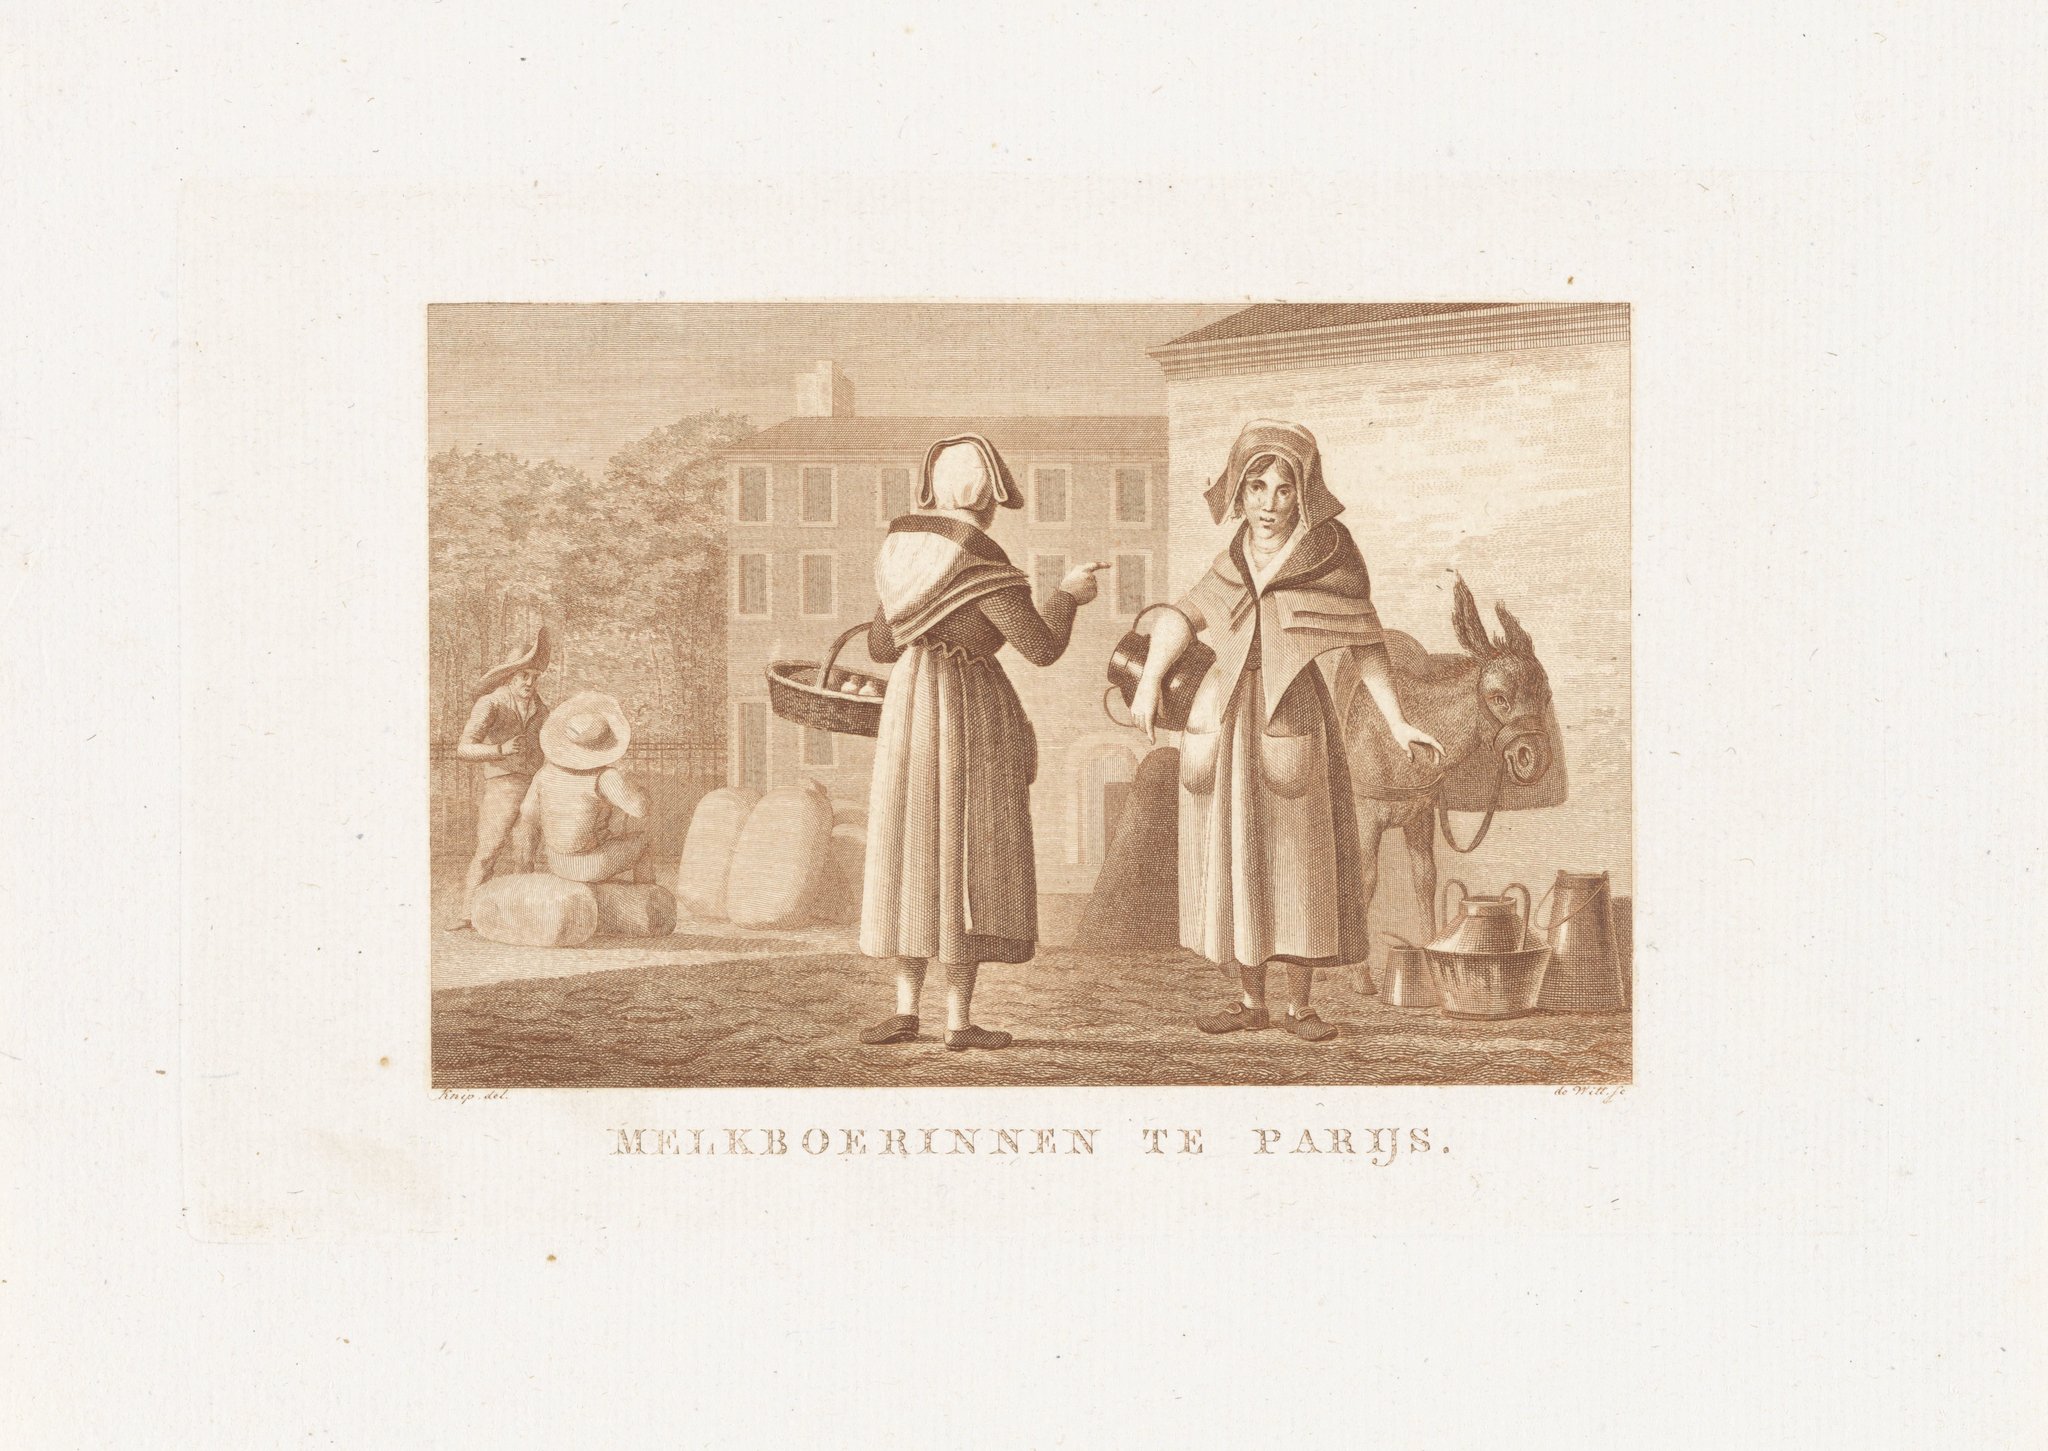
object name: print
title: Melkboerinnen te Parijs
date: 1798-1809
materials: paper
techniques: etching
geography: haarlem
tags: quarrel, argument, market, paris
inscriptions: collector's mark: Lugt 2228